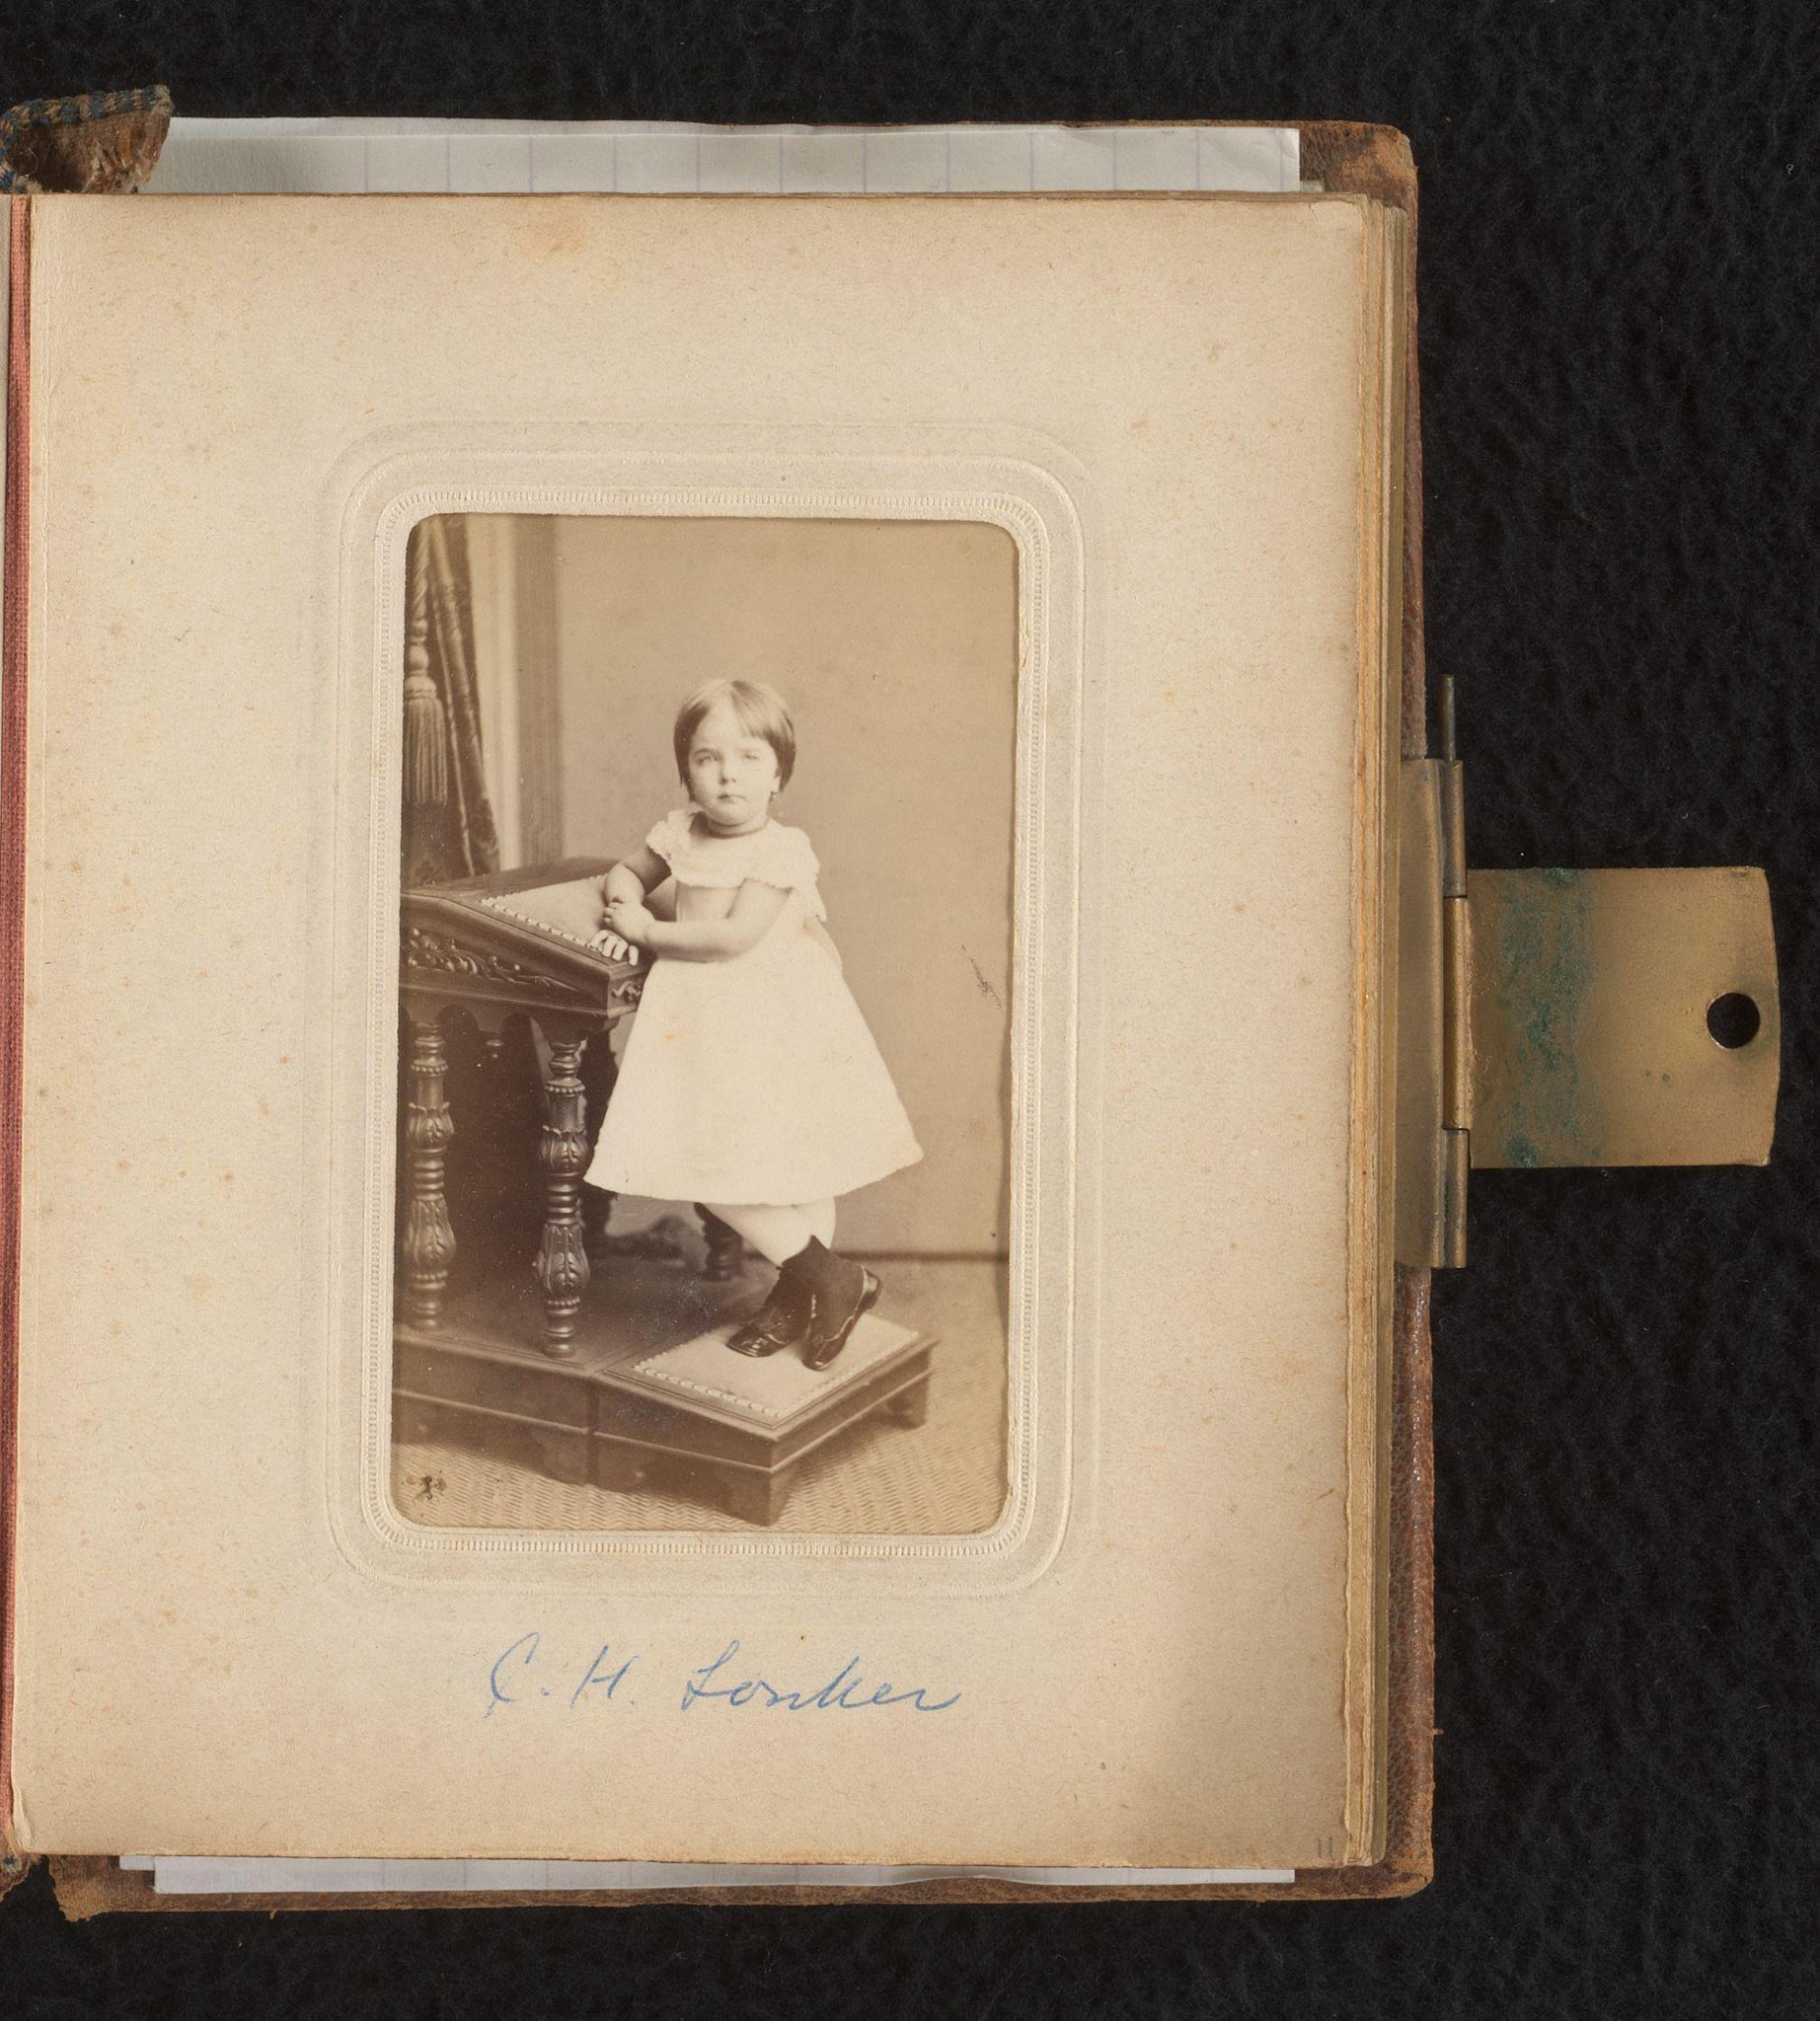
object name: carte de visite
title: Portret van Cornelia Hendrika Jonker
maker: albert greiner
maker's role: fotograaf, fotostudio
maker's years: 1833-1890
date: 1875-1885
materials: cardboard, photographic support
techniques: albumen print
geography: amsterdam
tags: cornelia hendrika jonker, historical persons - bb - woman, girl (child between toddler and youth)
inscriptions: name: ‘C.H. Jonker’, inscription: ‘A. Greiner/ Photograf/ Amsterdam/ Nieuwendijk L.89’